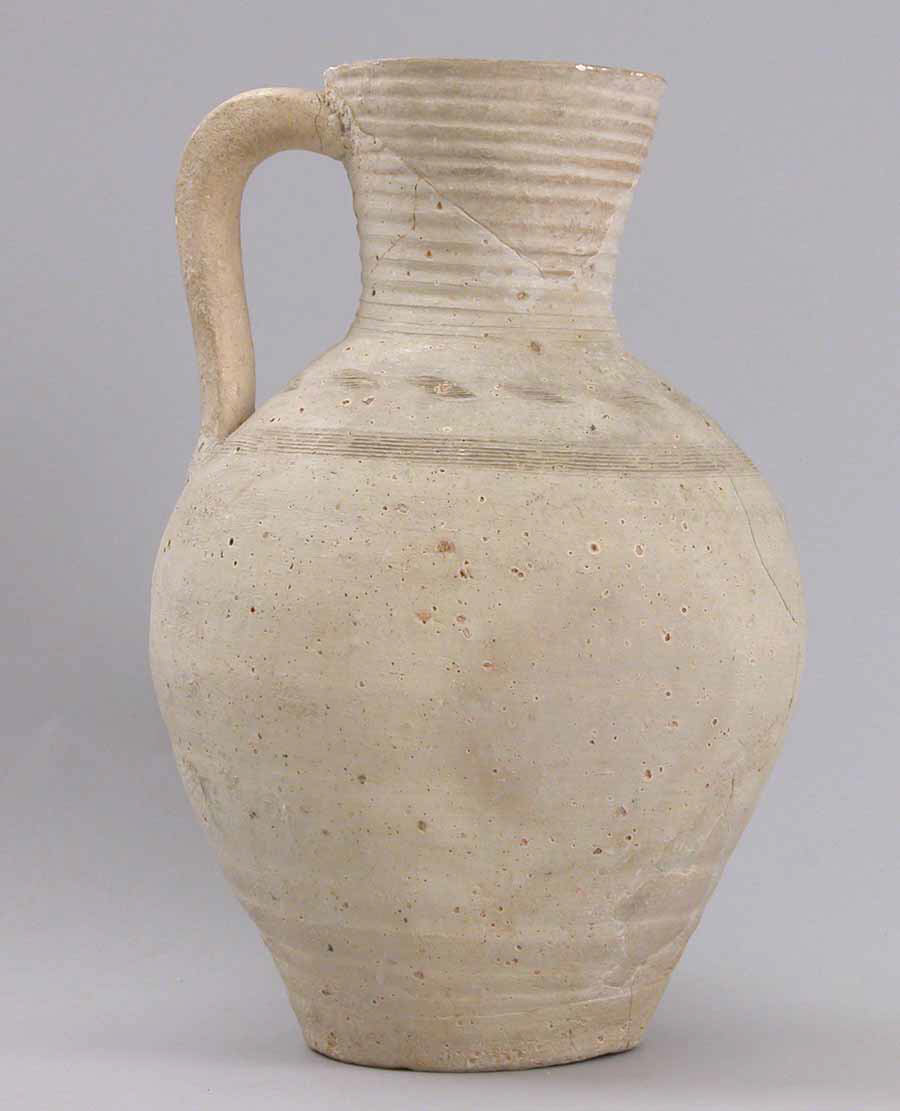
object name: ewer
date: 601-800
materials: earthenware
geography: iran